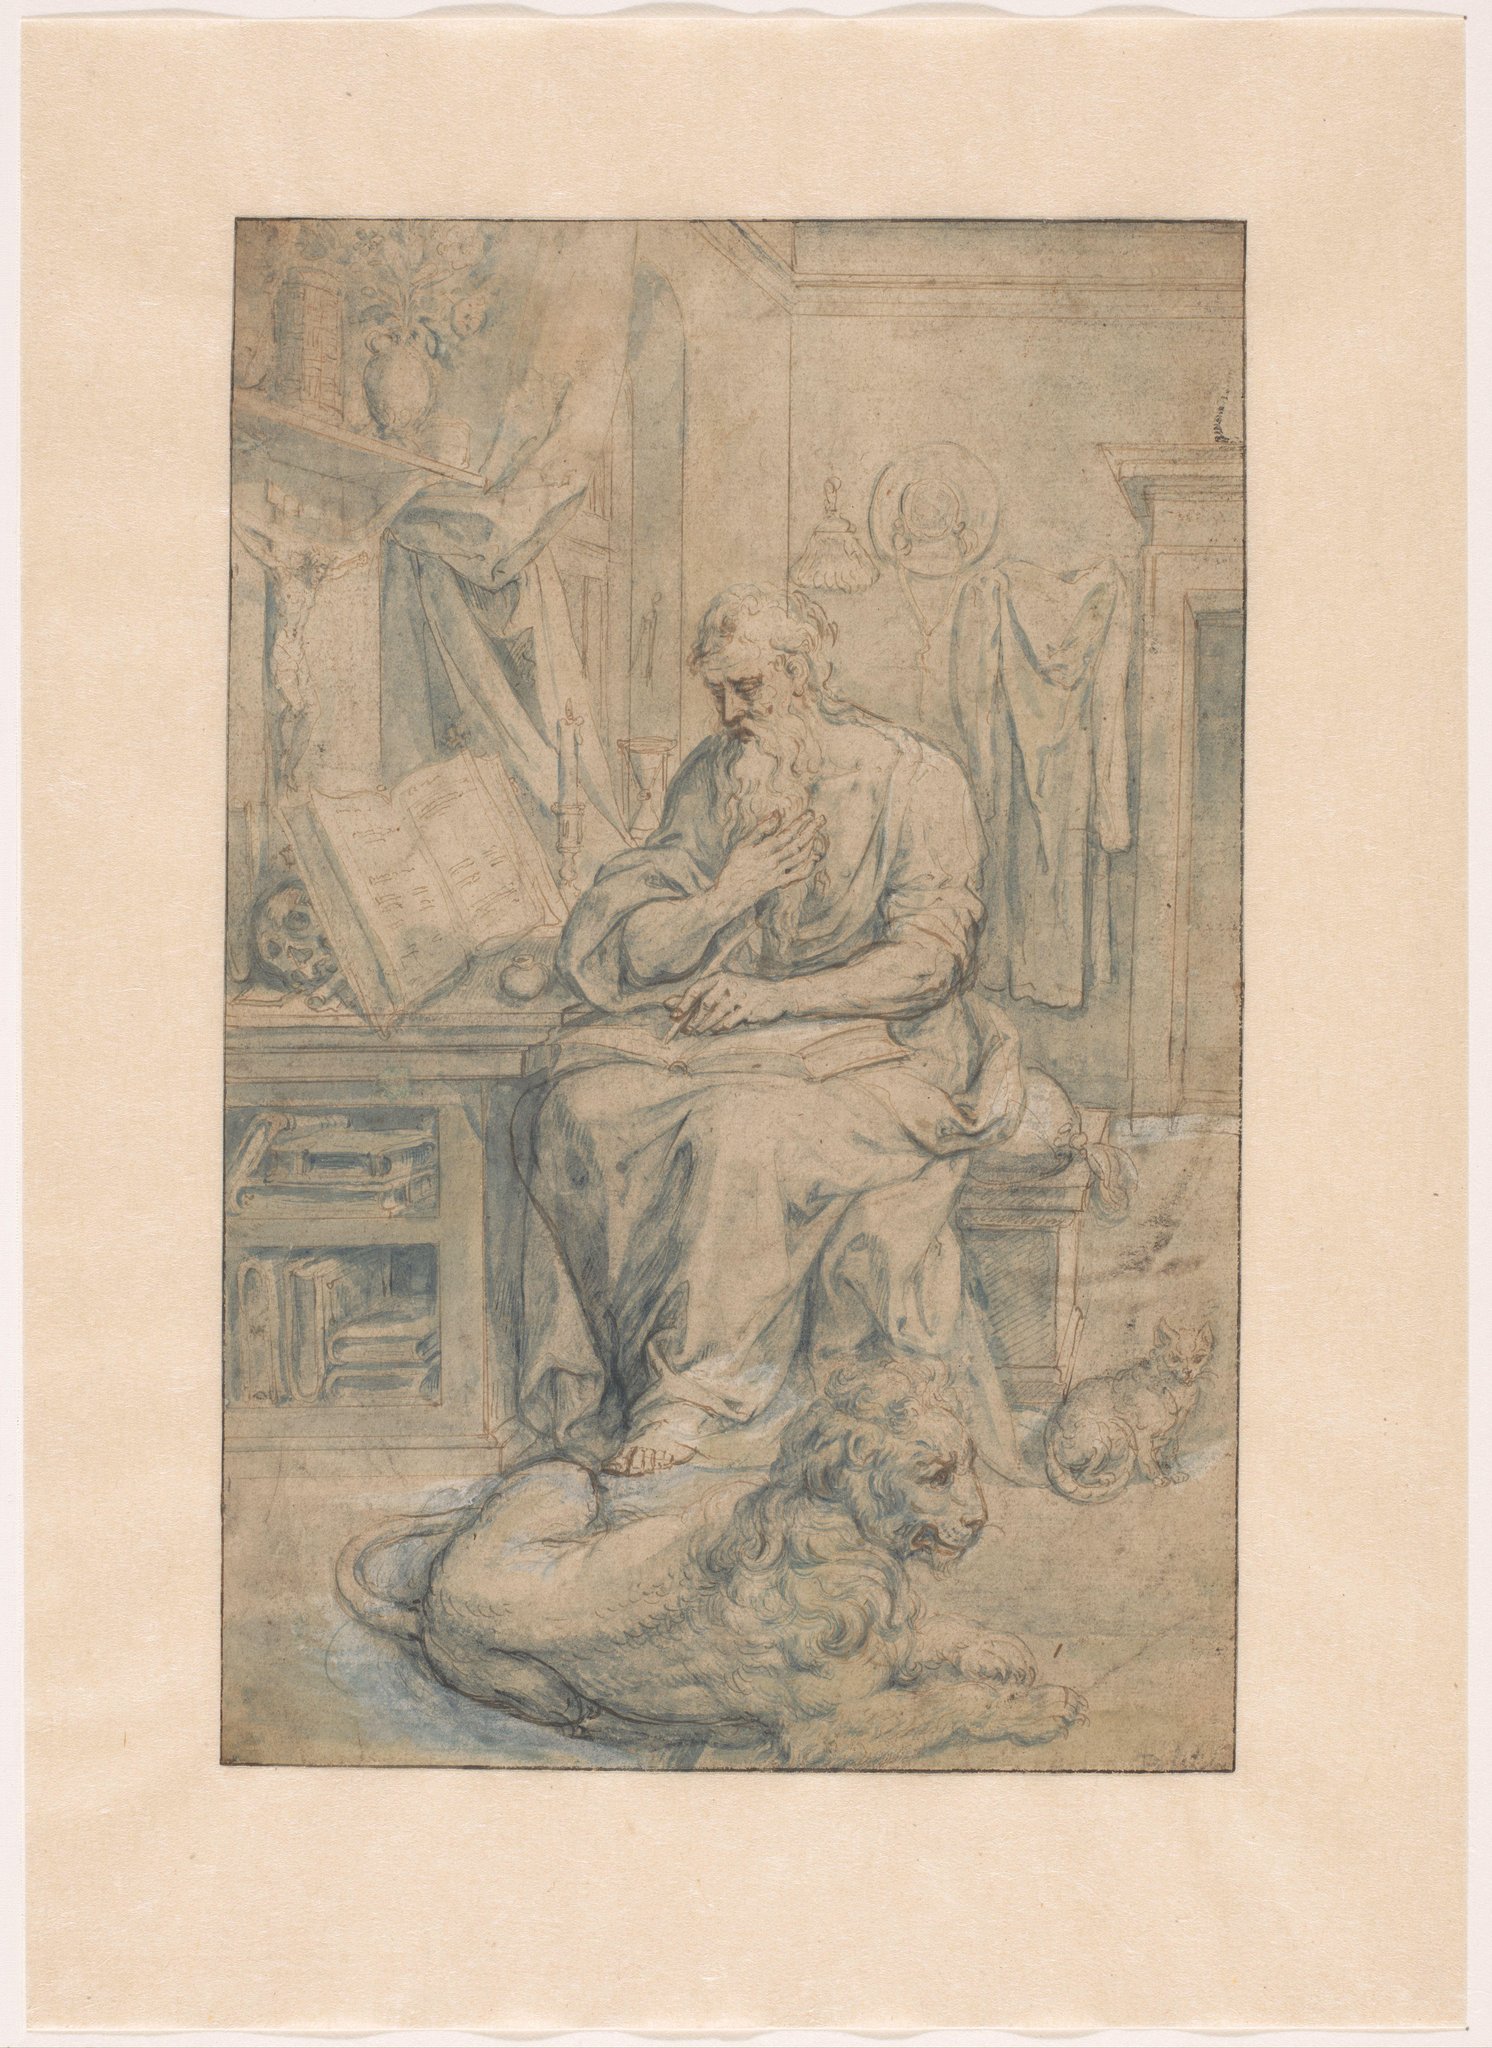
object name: drawing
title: De heilige Hieronymus in zijn studeervertrek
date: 1560-1580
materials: paint, ink, paper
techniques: brush, pen